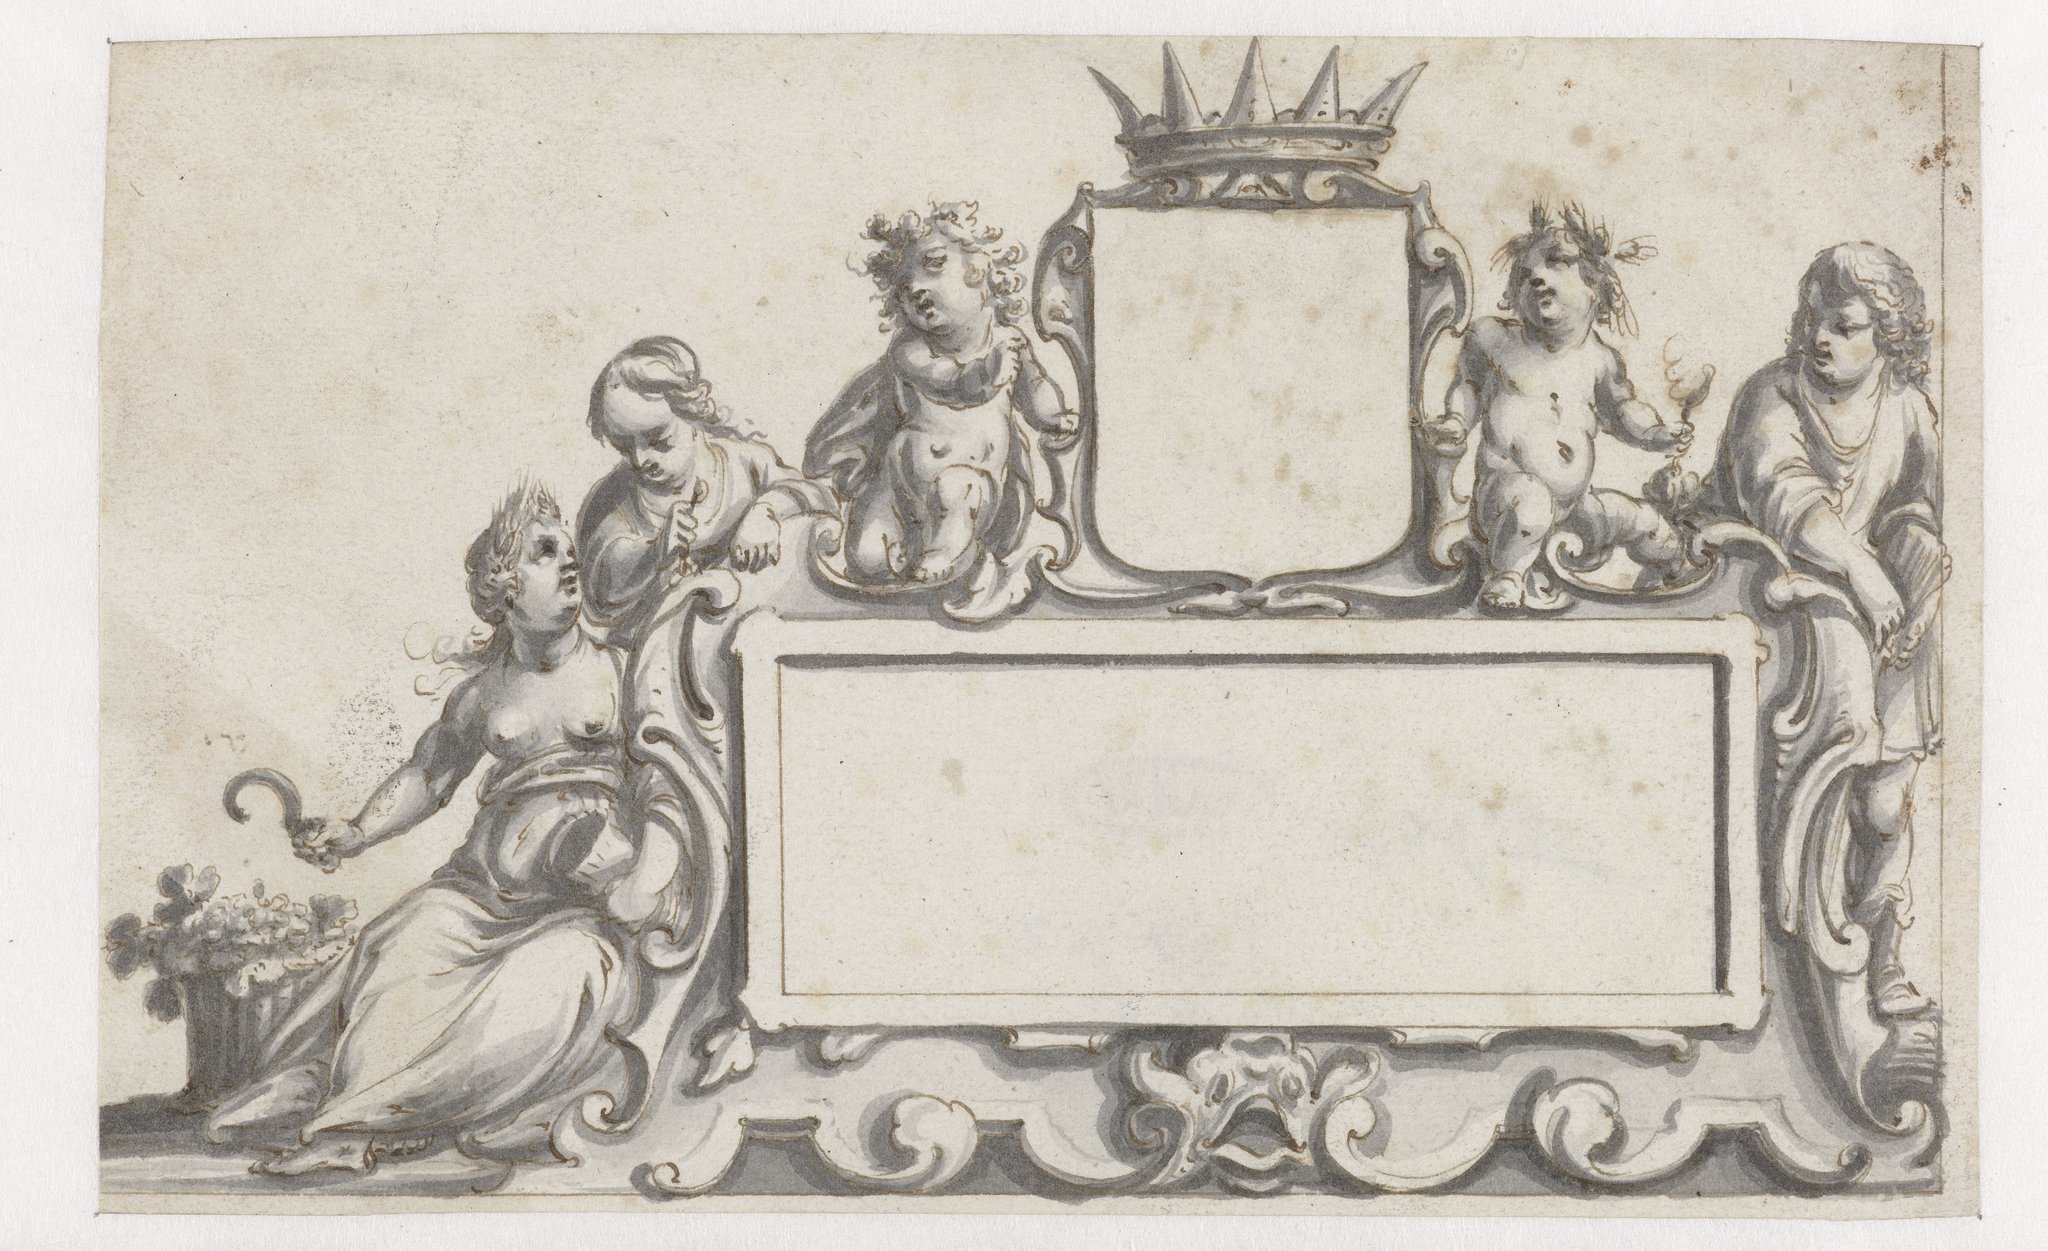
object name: design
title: Rechthoekige cartouche met een wapenschild en vijf figuren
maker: pieter jansz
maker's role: draughtsman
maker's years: 1602-1672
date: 1657-1662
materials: ink, paper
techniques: brush, pen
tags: coat of arms (as symbol of the state, etc.), female sex; woman, ornament ~ cartouche, male sex; man